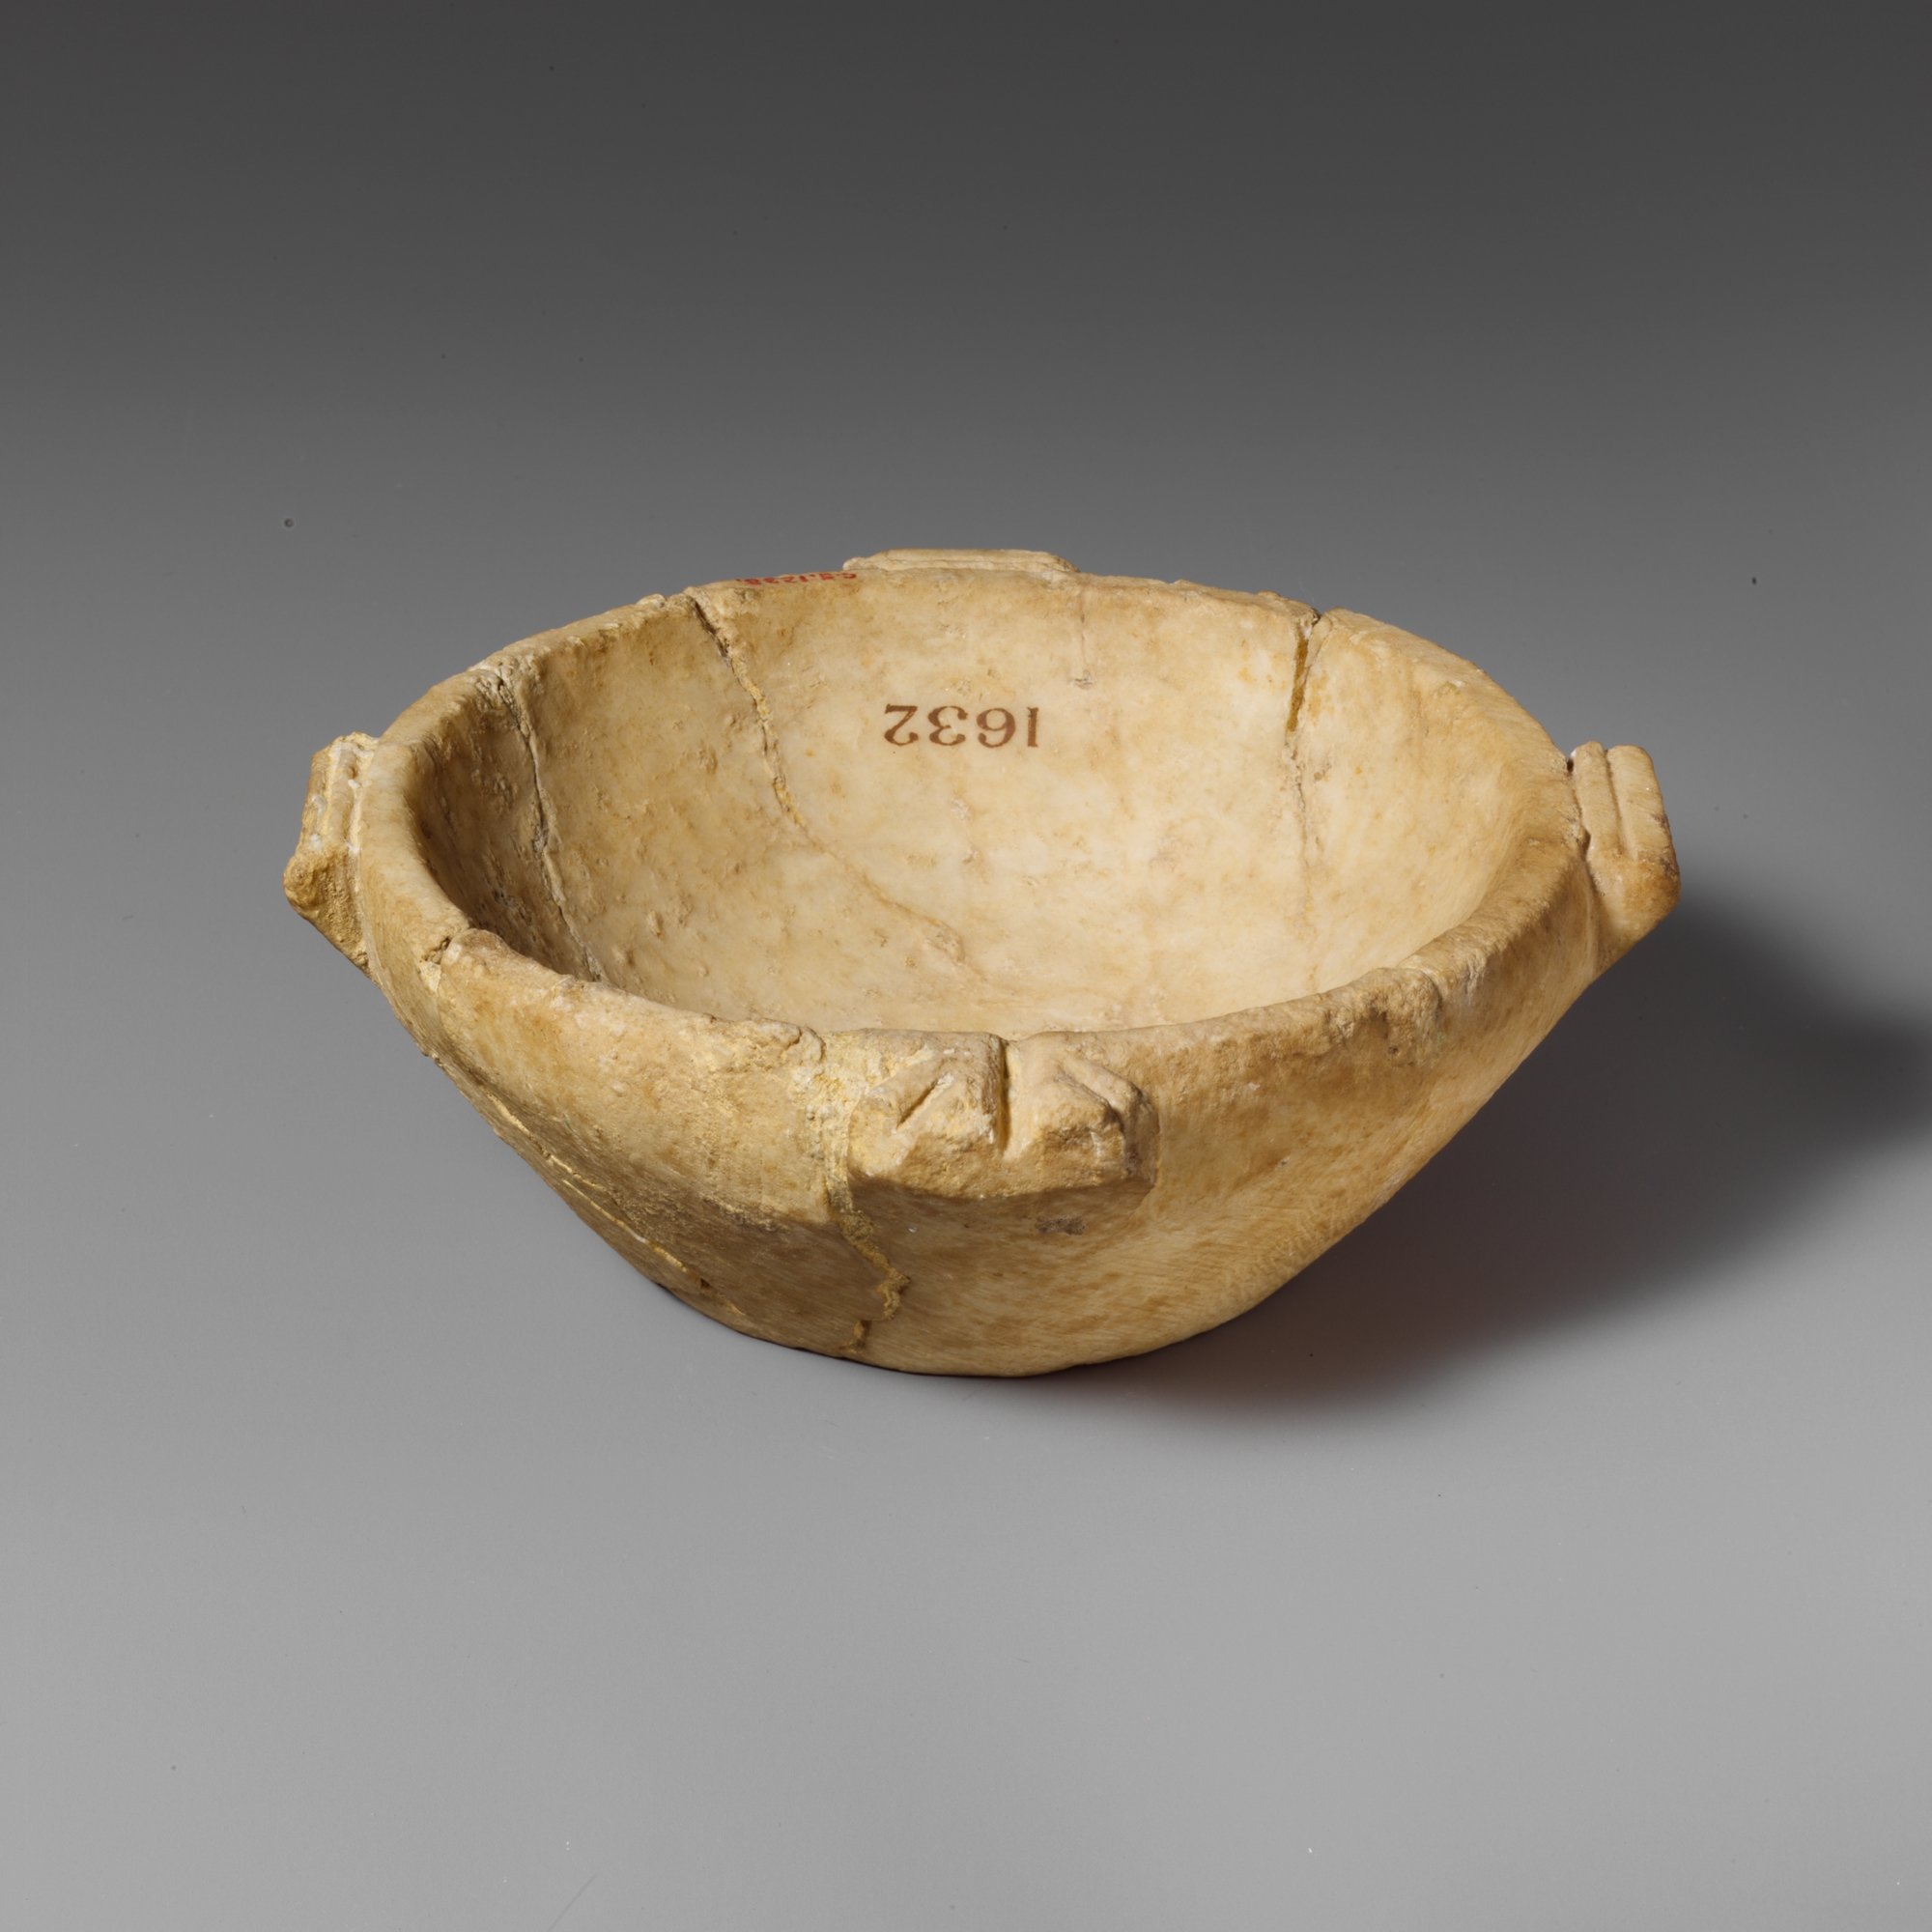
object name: bowl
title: Alabaster mortar or deep bowl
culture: cypriot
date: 1600-1050 BCE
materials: gypsum